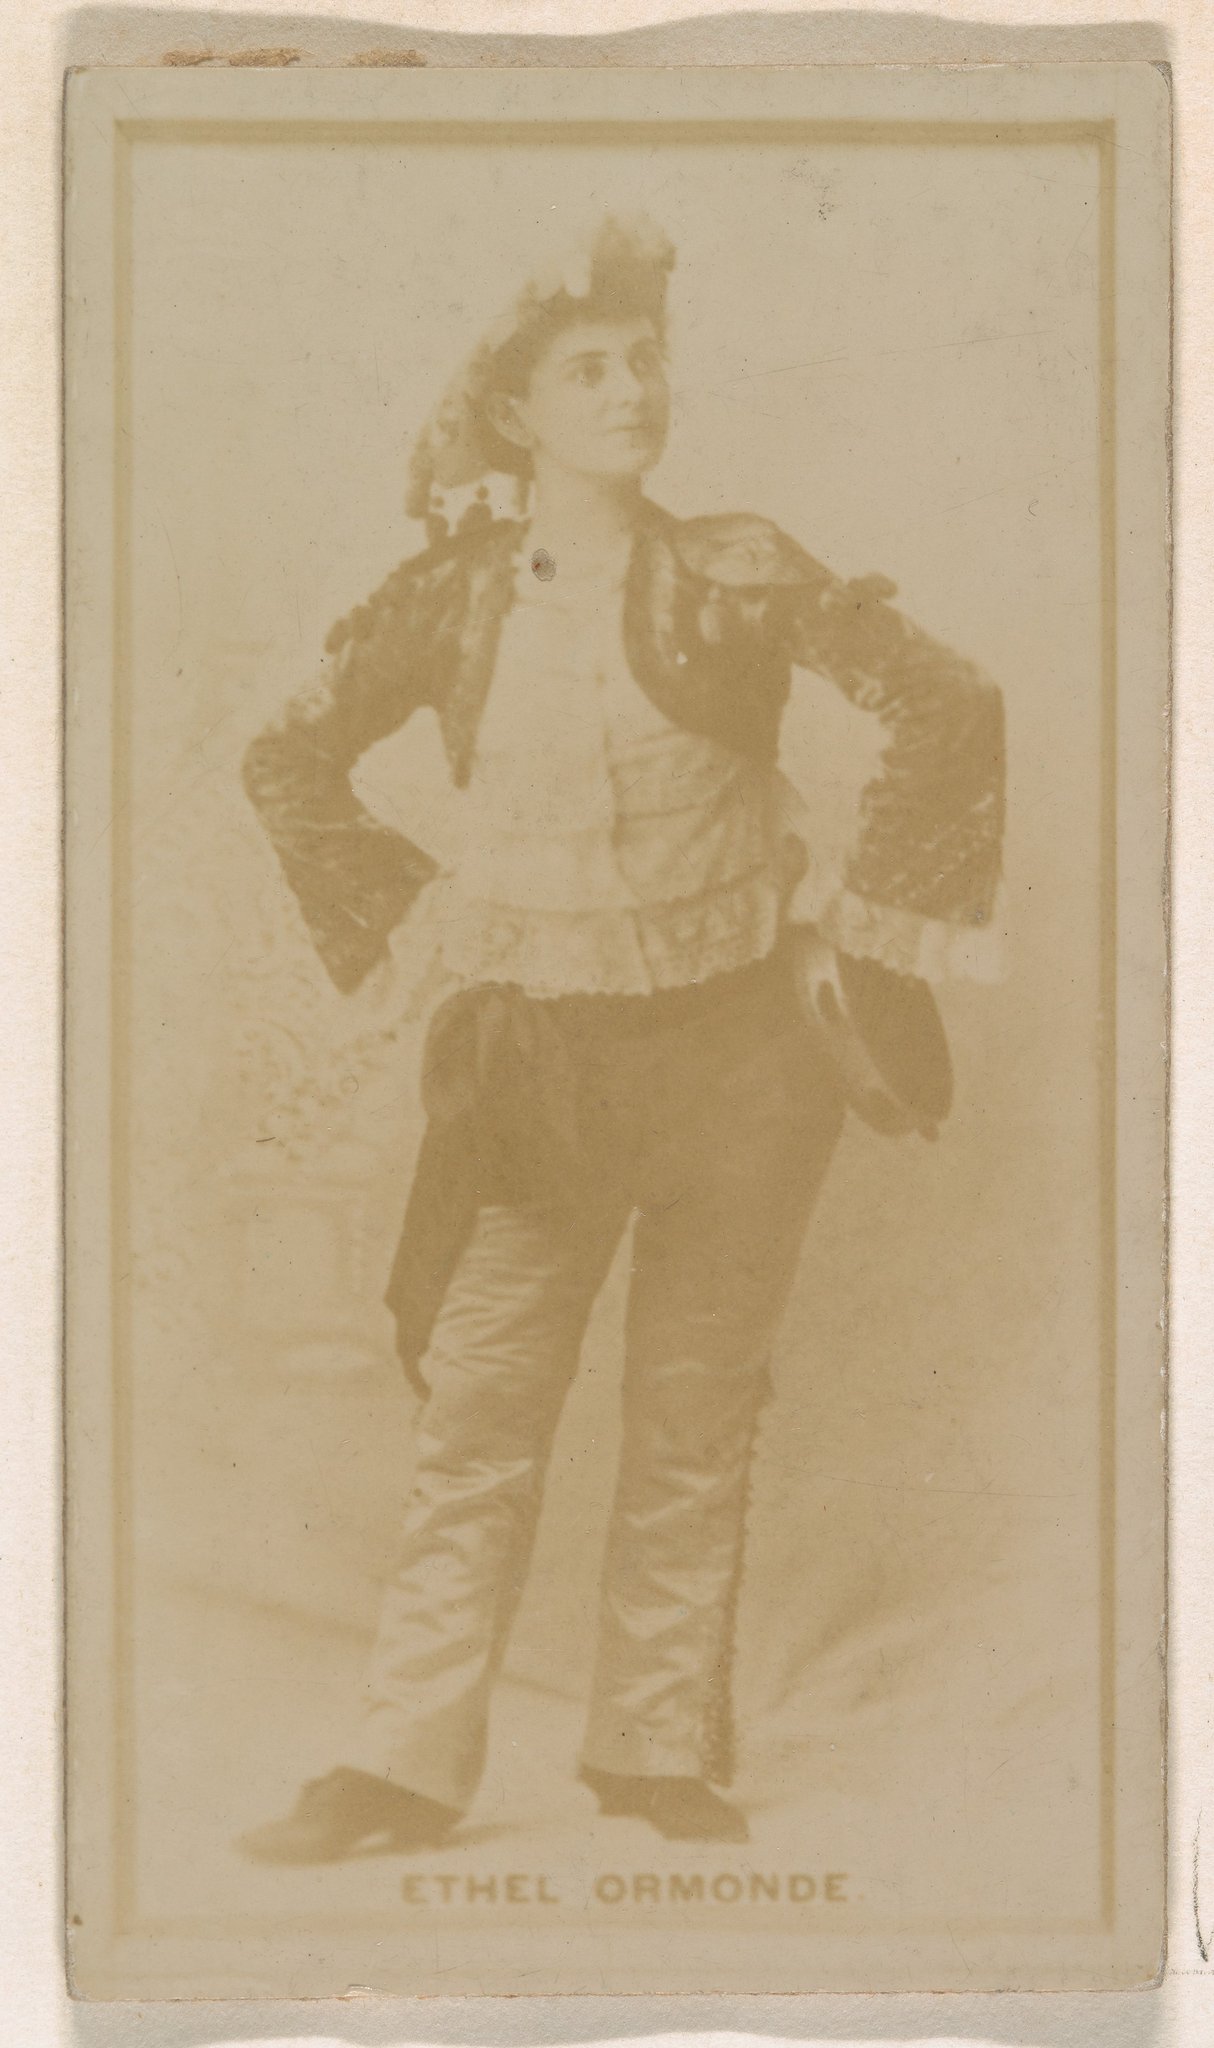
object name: photograph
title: Ethel Ormonde, from the Actresses series (N245) issued by Kinney Brothers to promote Sweet Caporal Cigarettes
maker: kinney brothers tobacco company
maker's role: publisher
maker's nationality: american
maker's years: 1869-2011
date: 1890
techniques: albumen silver print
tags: portraits,women,actresses